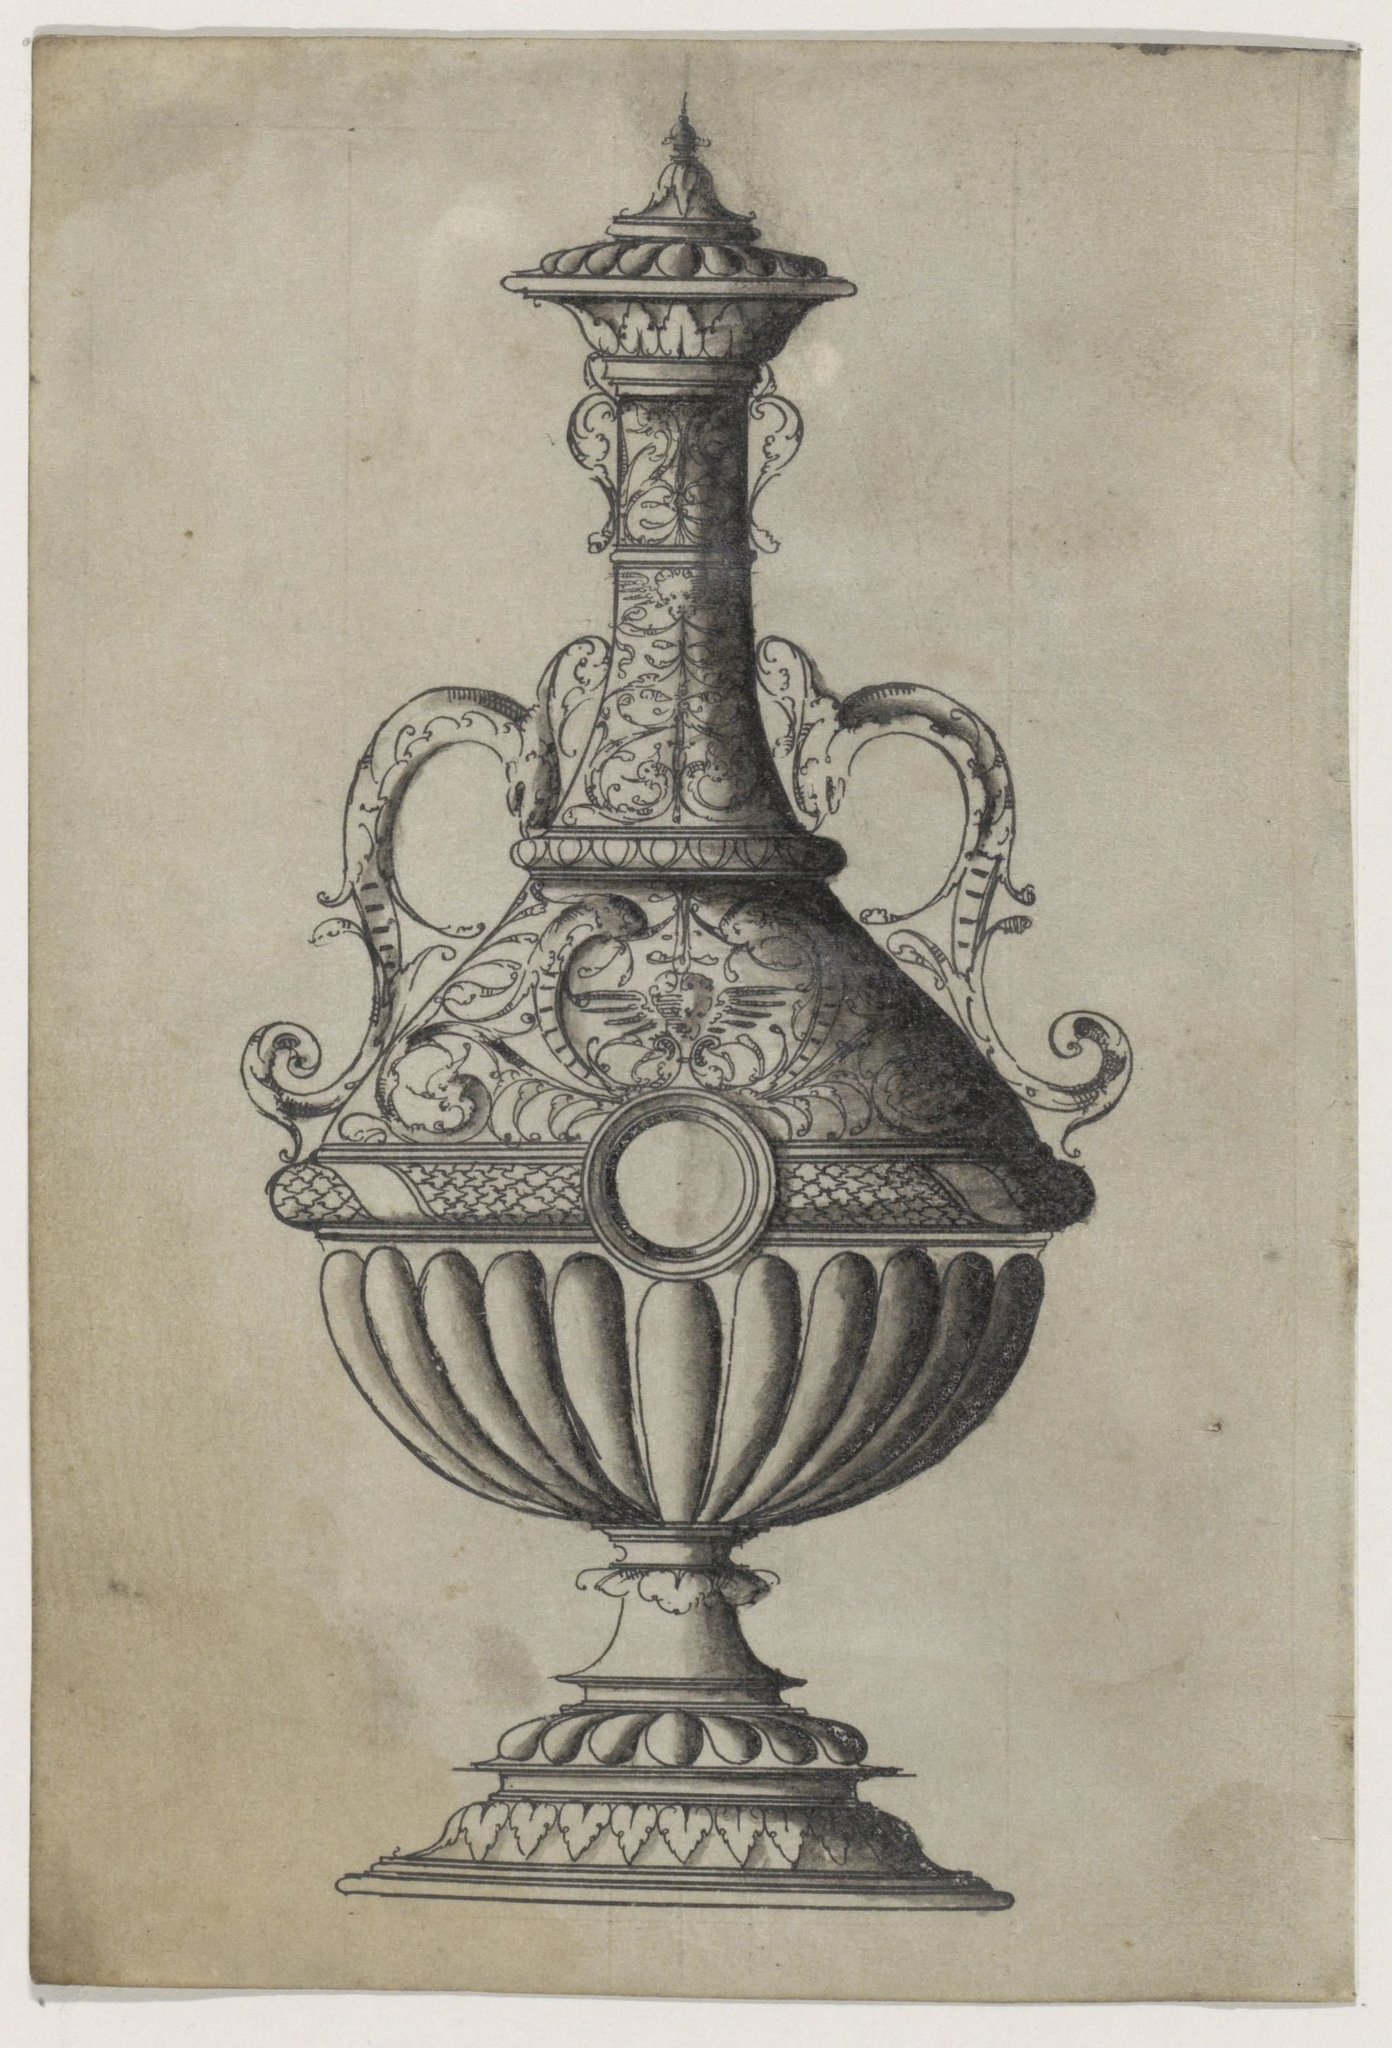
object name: album leaf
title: Vaas met een lange hals en twee oren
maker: jacques androuet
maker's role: draughtsman, print maker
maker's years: 1515-1584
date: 1543-1553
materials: ink, parchment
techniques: brush, pen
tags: container of stone: stone vase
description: Blad 3 verso, los opgezet blad uit een album bestaande uit een band met twee bladen, een schutblad en zeventien apart opgezette bladen.